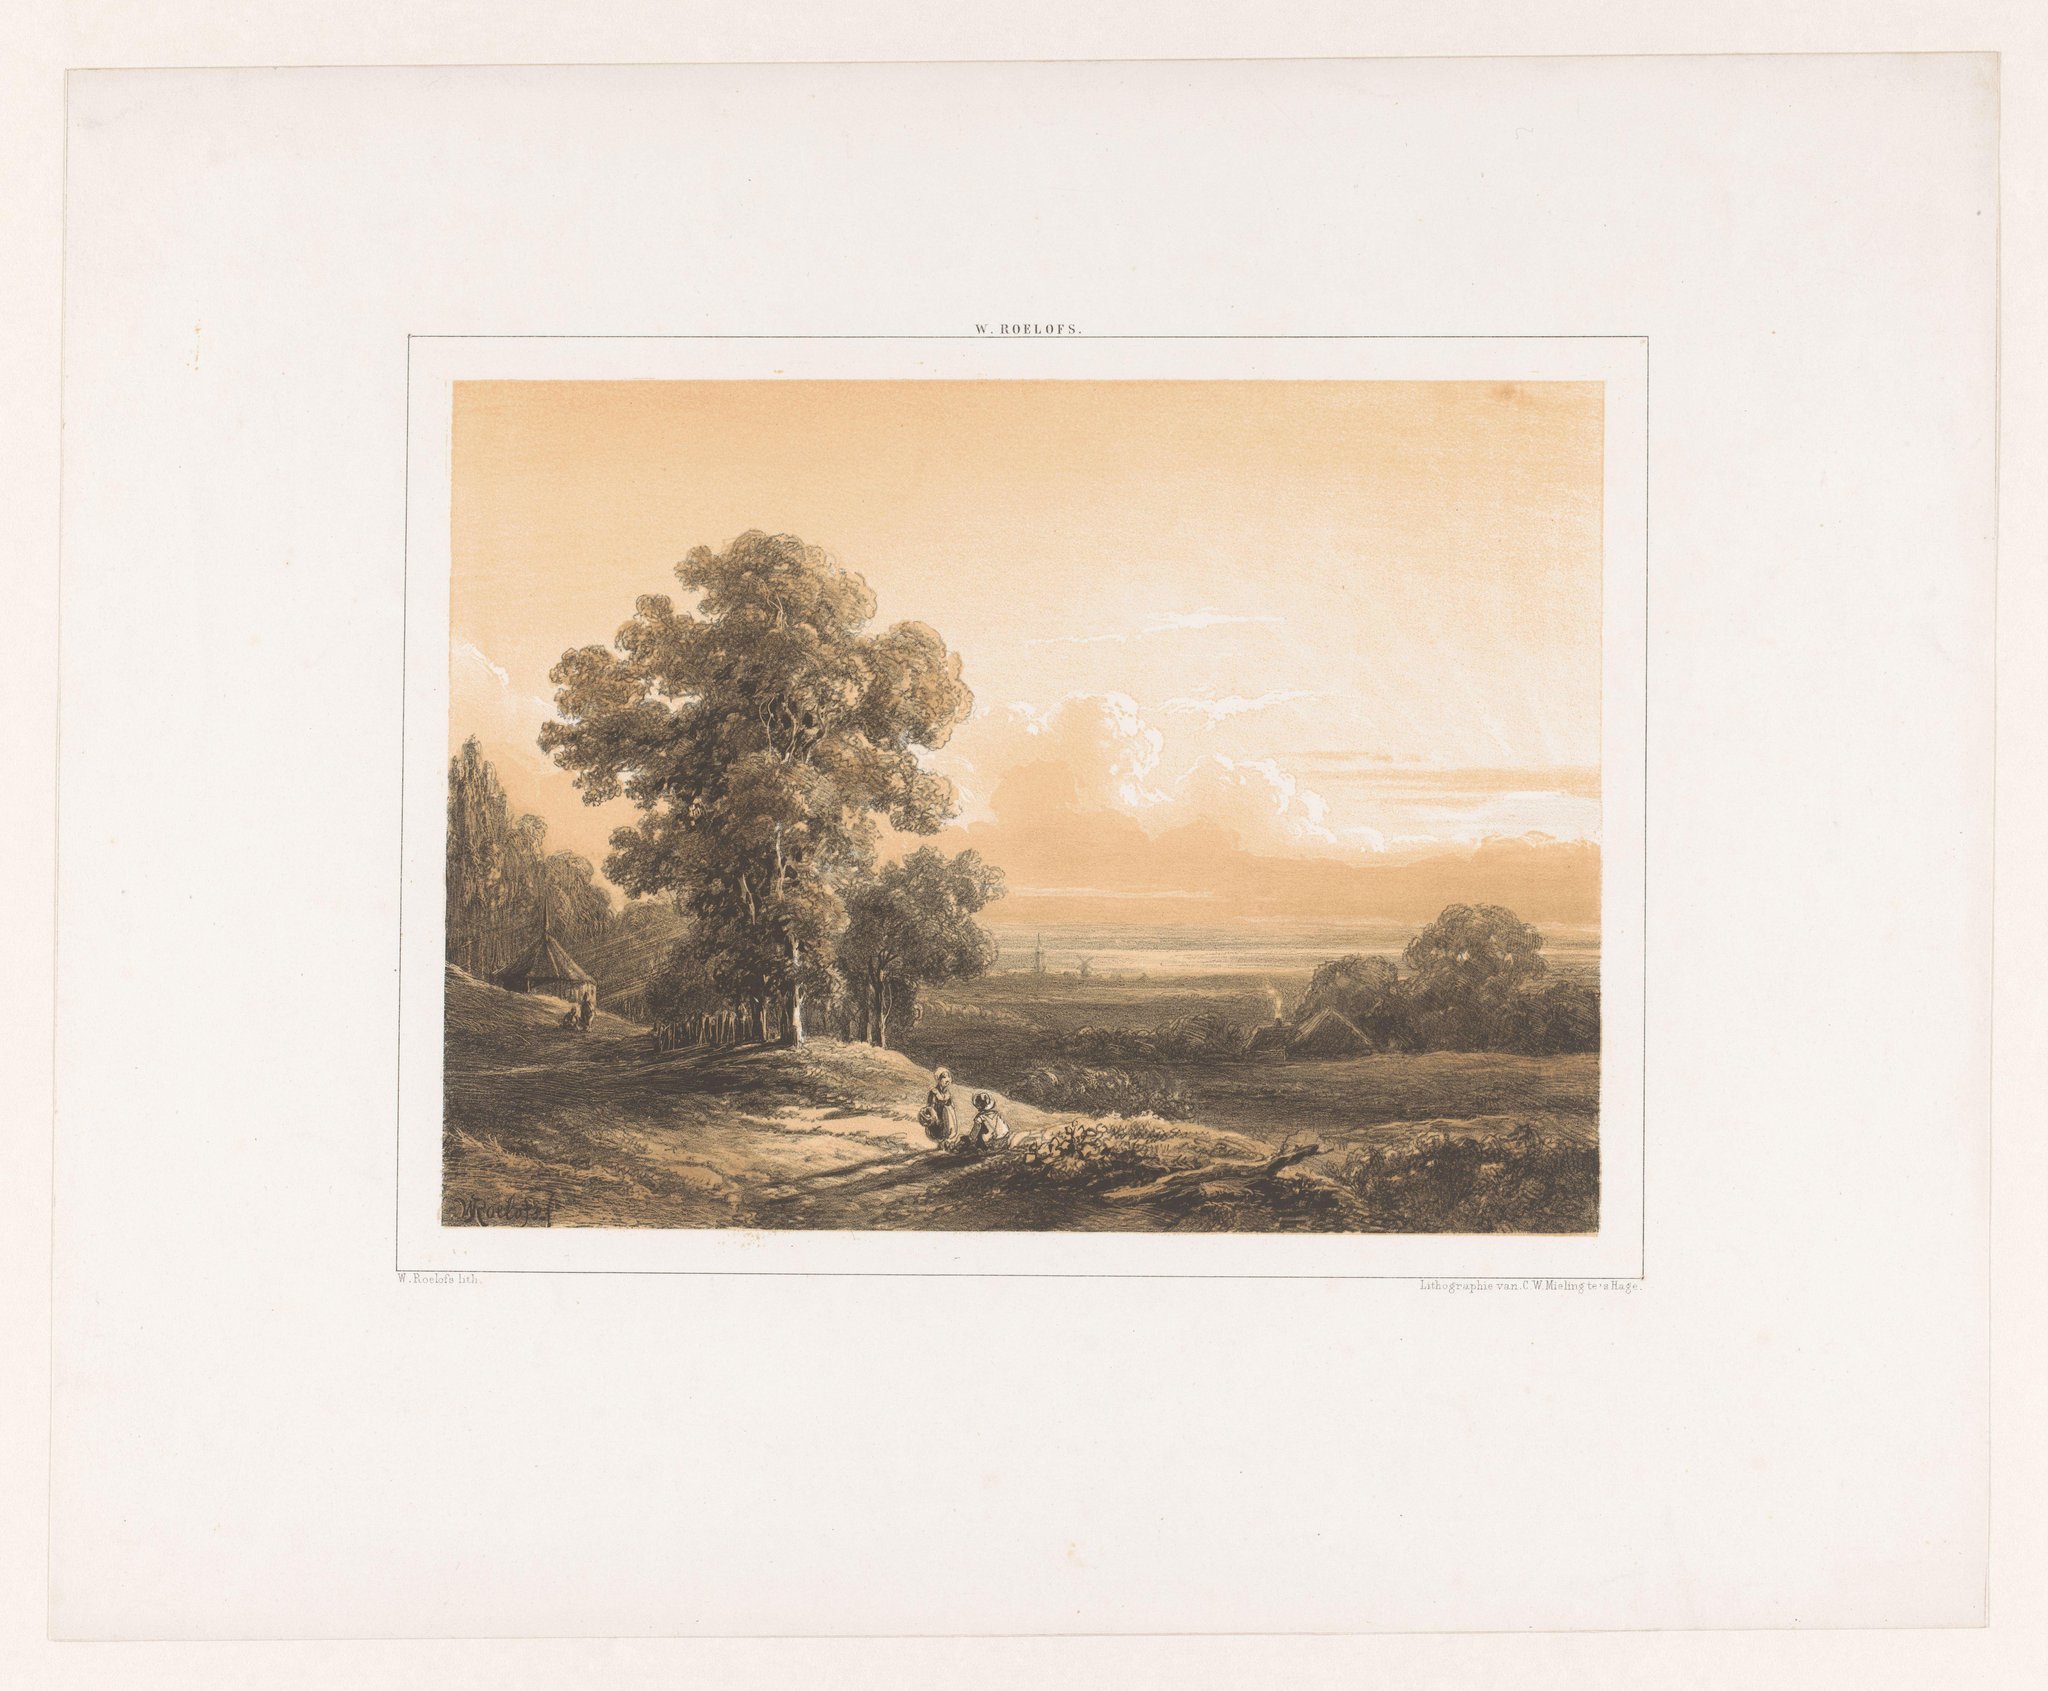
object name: print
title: Landschap met twee figuren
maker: willem roelofs (i)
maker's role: draughtsman, painter, print maker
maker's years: 1822-1897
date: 1847-1864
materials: paper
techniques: tone lithography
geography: the hague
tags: landscapes (+ landscape with figures, staffage)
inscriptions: collector's mark: Lugt 2166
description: Een vrouw met mand staat tegenover een zittende man in een landschap met boompartijen en woningen. In de achtergrond een kerktoren en molen.